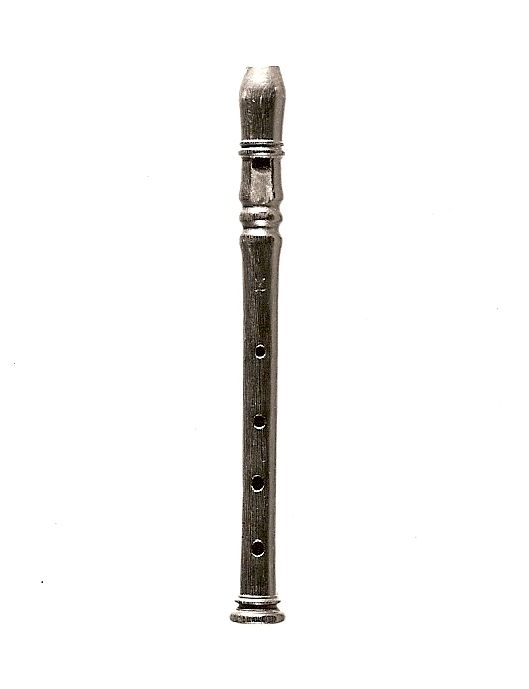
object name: flageolet in e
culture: french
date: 1701-1800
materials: wood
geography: france or germany